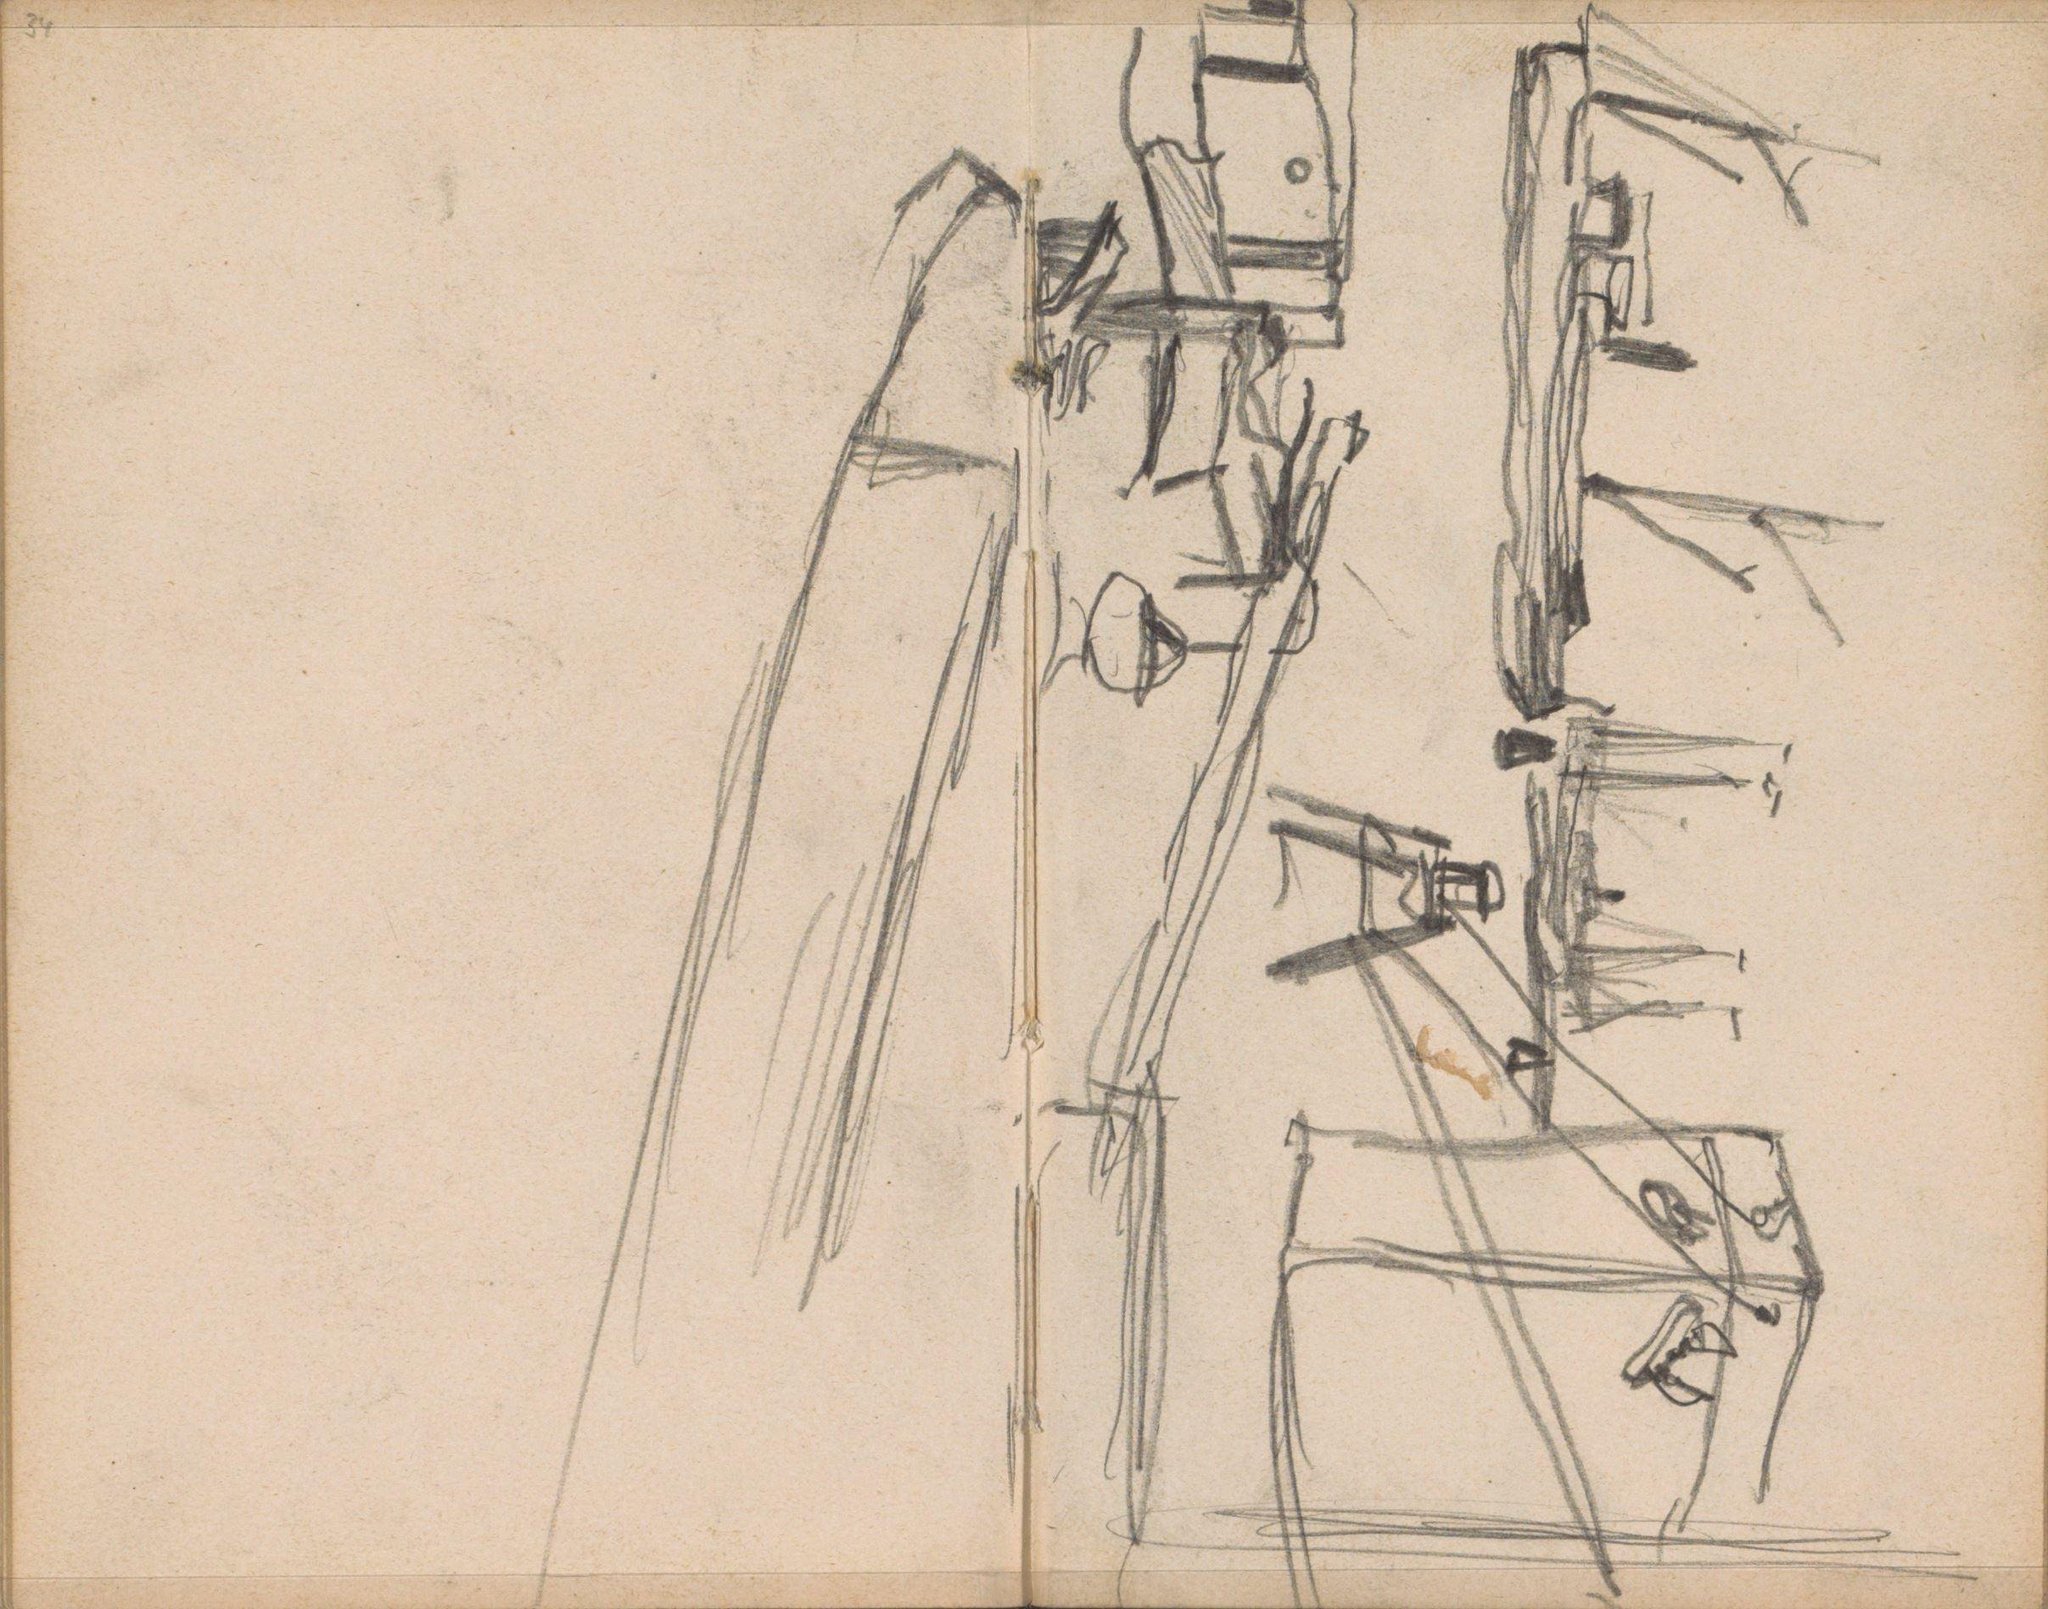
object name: sketchbook leaf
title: Schepen op het IJ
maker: george hendrik breitner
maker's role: draughtsman, painter, print maker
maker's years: 1857-1923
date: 1892-1923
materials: paper, pencil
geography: amsterdam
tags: ships (in general)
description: Schepen op het IJ. Pagina 34 en pagina 35 uit een schetsboek met 45 bladen vervaardigd te Schwerin en Amsterdam.